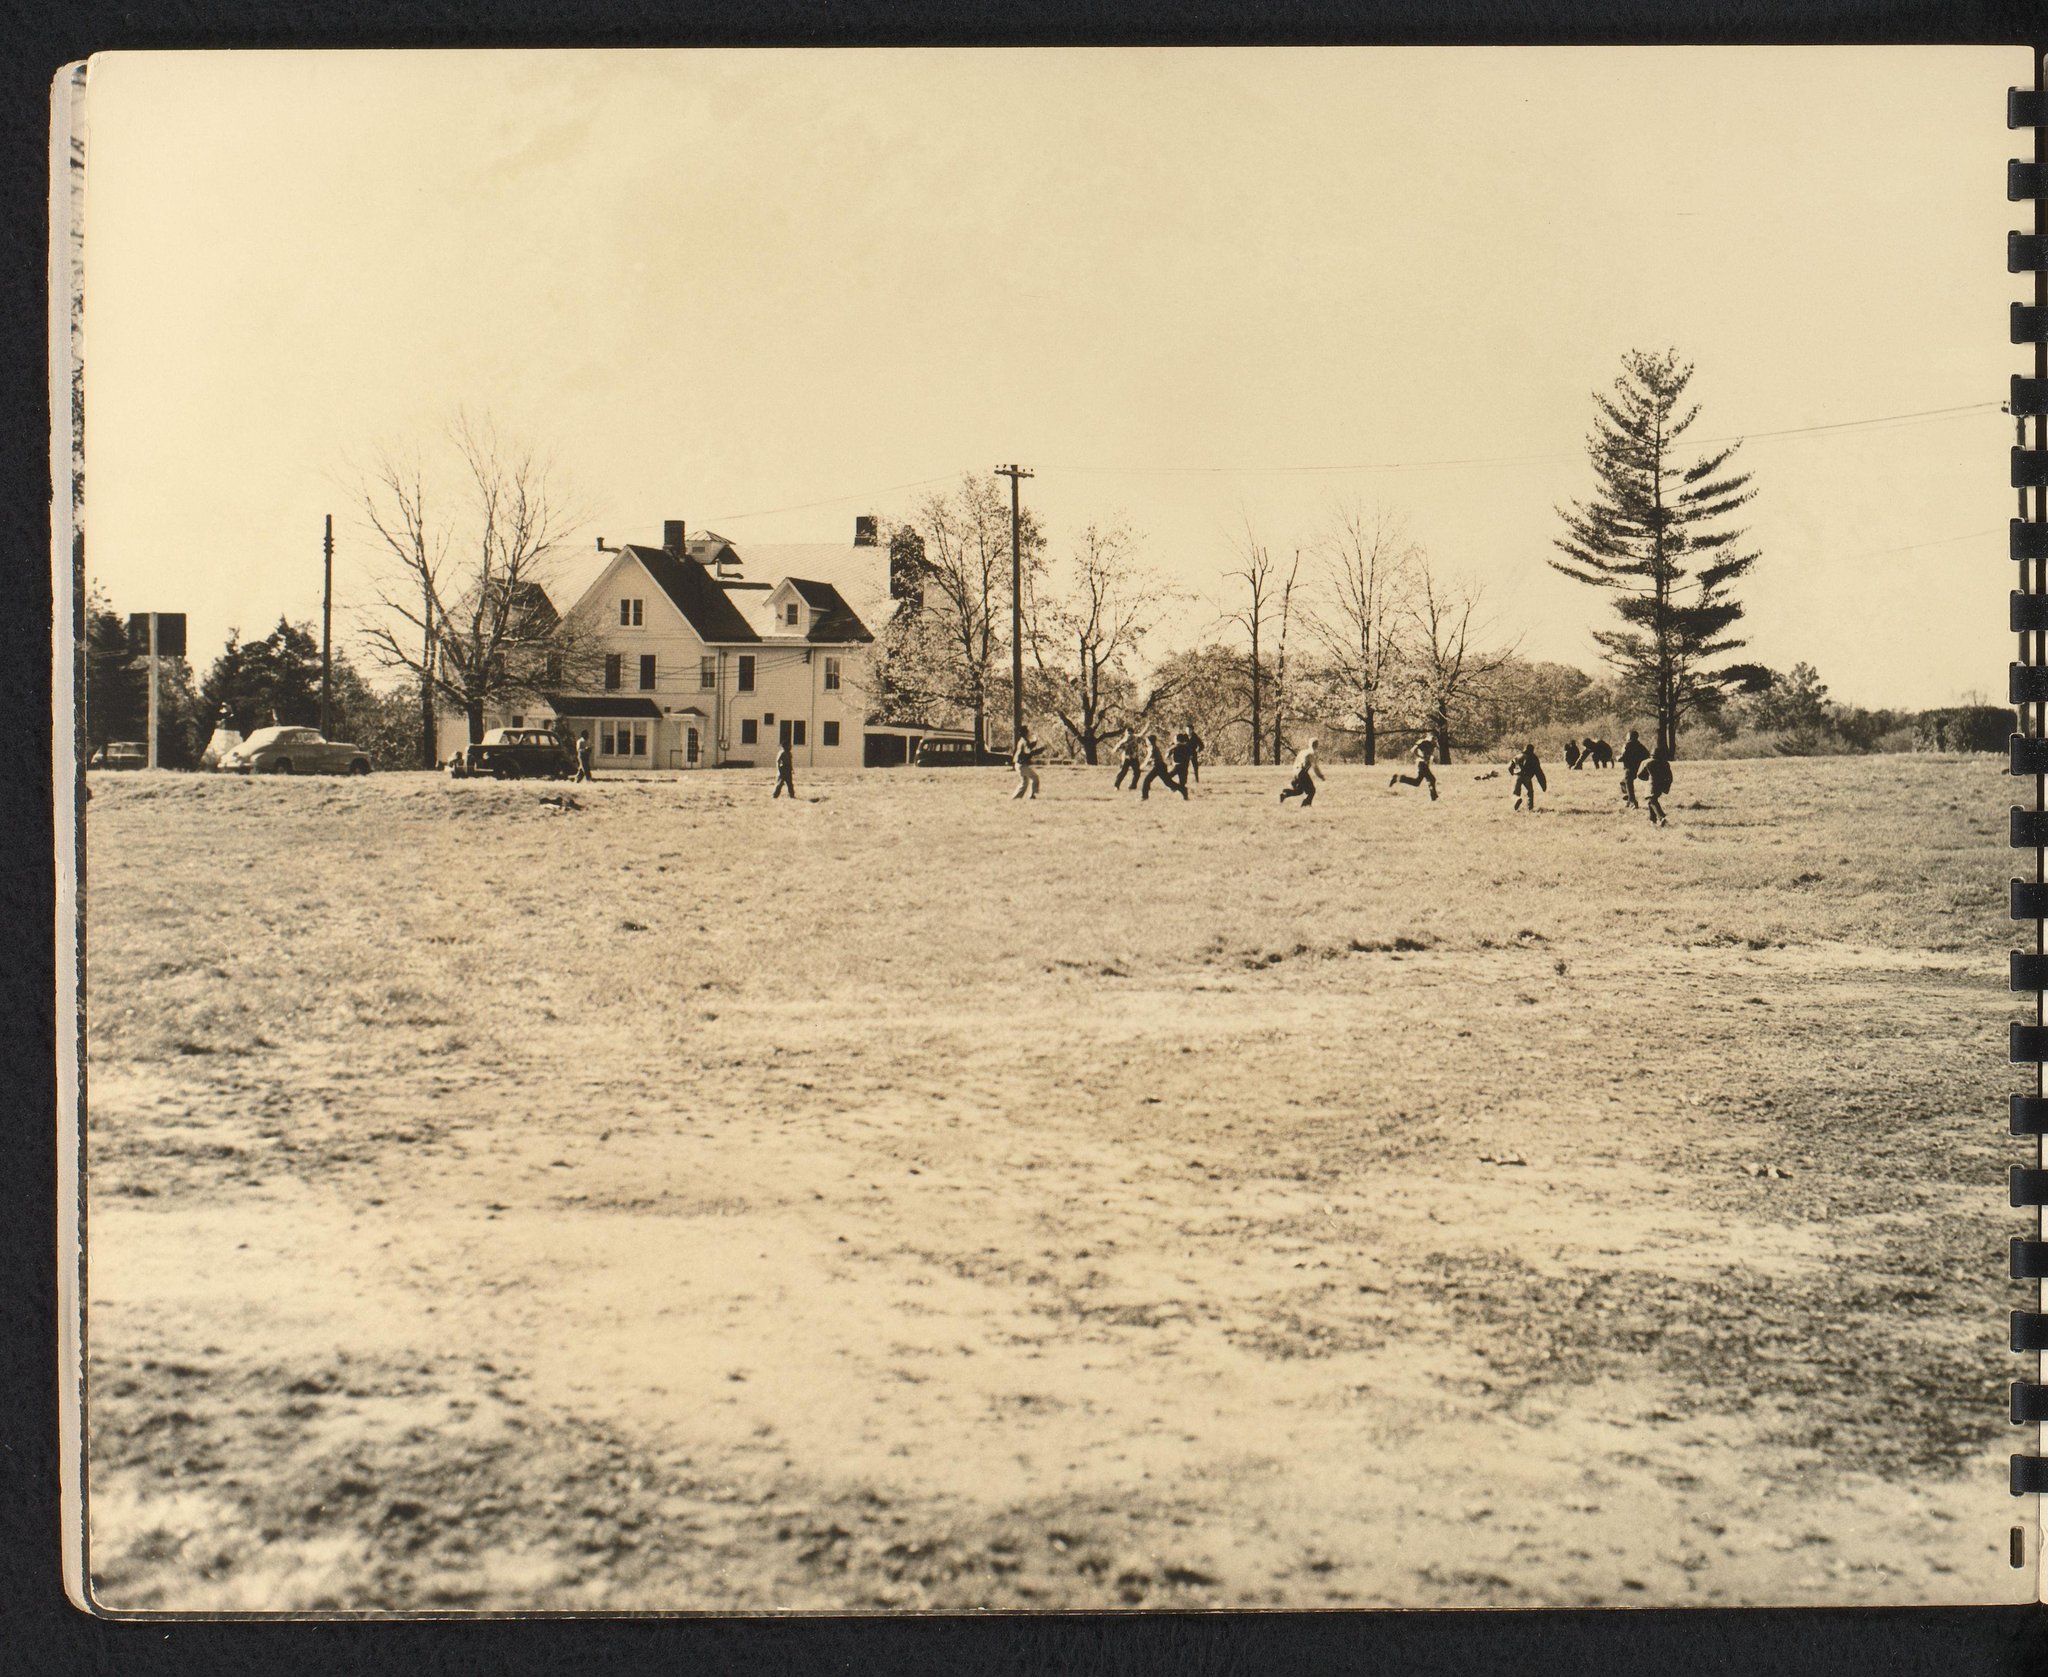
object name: photograph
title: Speelveld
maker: Anonymous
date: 1950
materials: paper, photographic support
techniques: gelatin silver print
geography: new york city